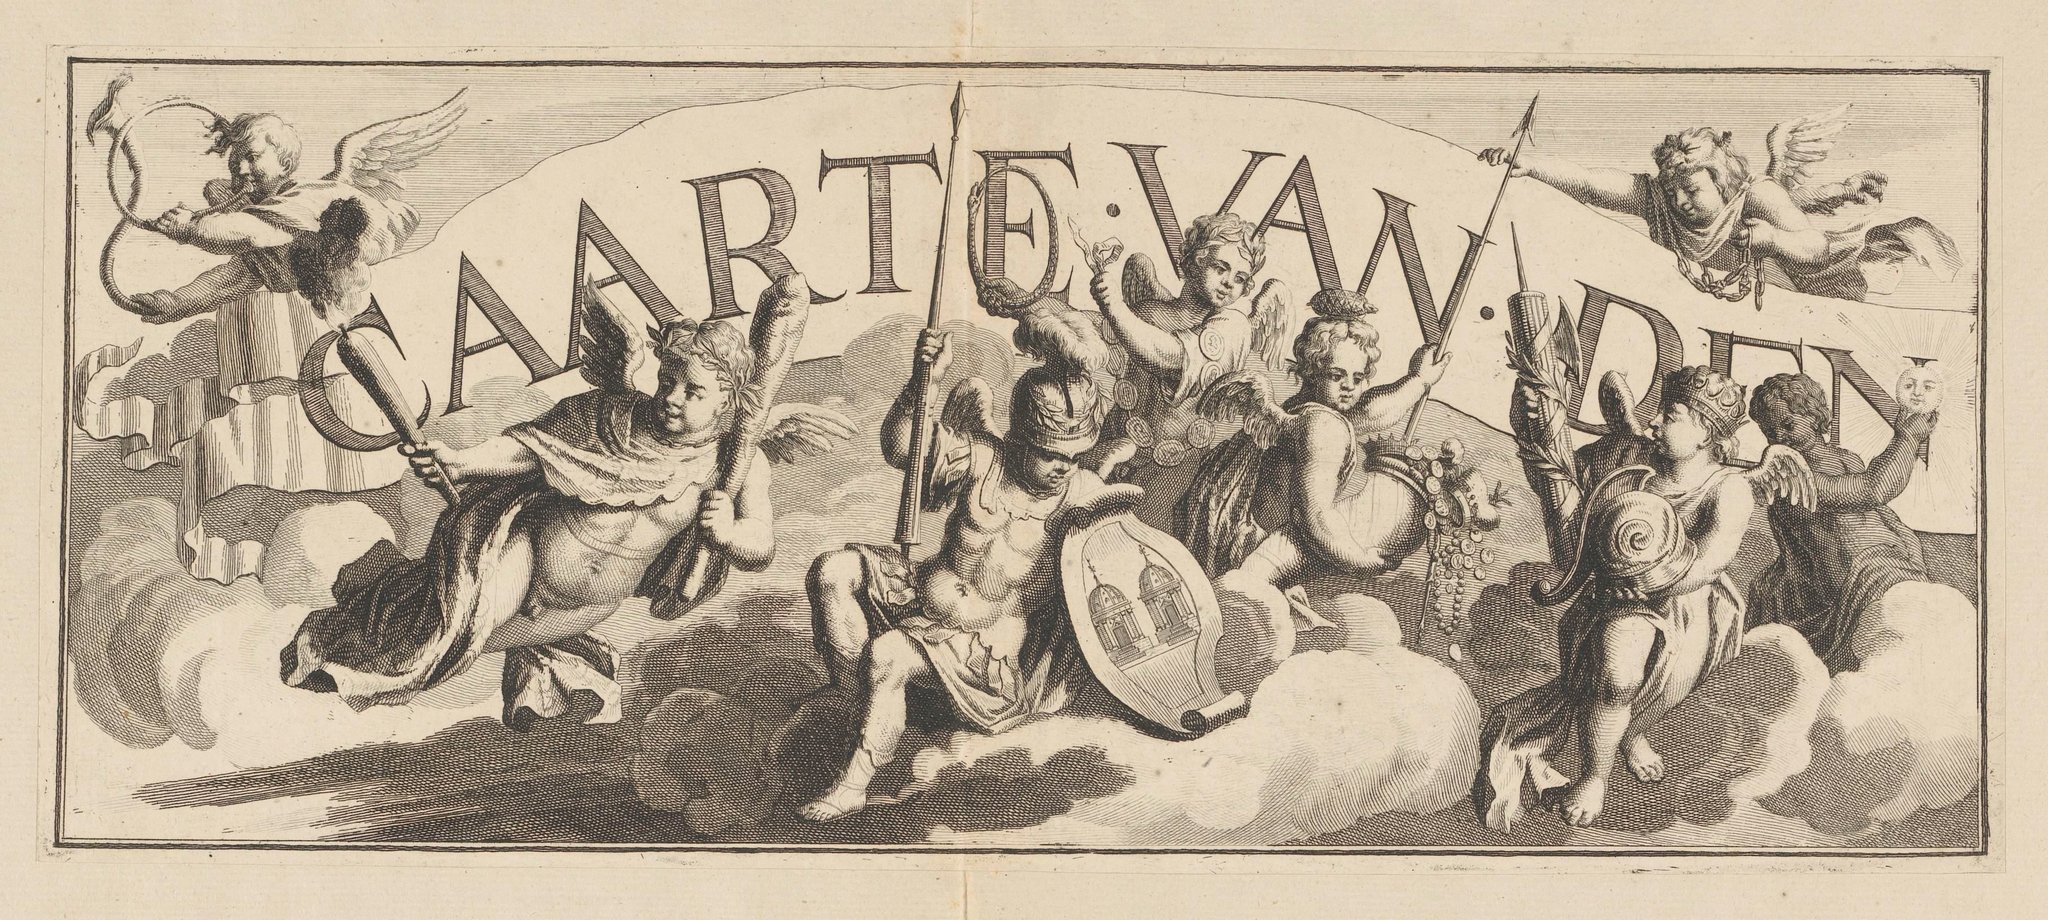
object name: print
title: Het Heemraatschap van den Overwaart groot 12728 1/6 mergen; gesticht by hertog Albrecht van Beyeren, Ao. 1366 / Caerte vertoonende de landen etc. van den Overwaert gelegen binnen den Ringdyk van den Alblasserwaert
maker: jan van vianen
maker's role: print maker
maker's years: 1660-1726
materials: paper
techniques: engraving, etching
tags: coat of arms (as symbol of the state, etc.), cupids: 'amores', 'amoretti', 'putti'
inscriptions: collector's mark: Lugt 195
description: Zie RP-P-AO-14-13 voor een proefdruk van de bijhorende kaart. In de collectie Atlas Ottens zijn slechts dit en nog één ander blad (RP-P-AO-14-13-6) van de sierrand te vinden. De sierrand bestond naast deze twee bladen met de titel 'Caarte van den Overwaart' uit allegorische voorstellingen en de wapens van de bestuursleden van het waterschap.